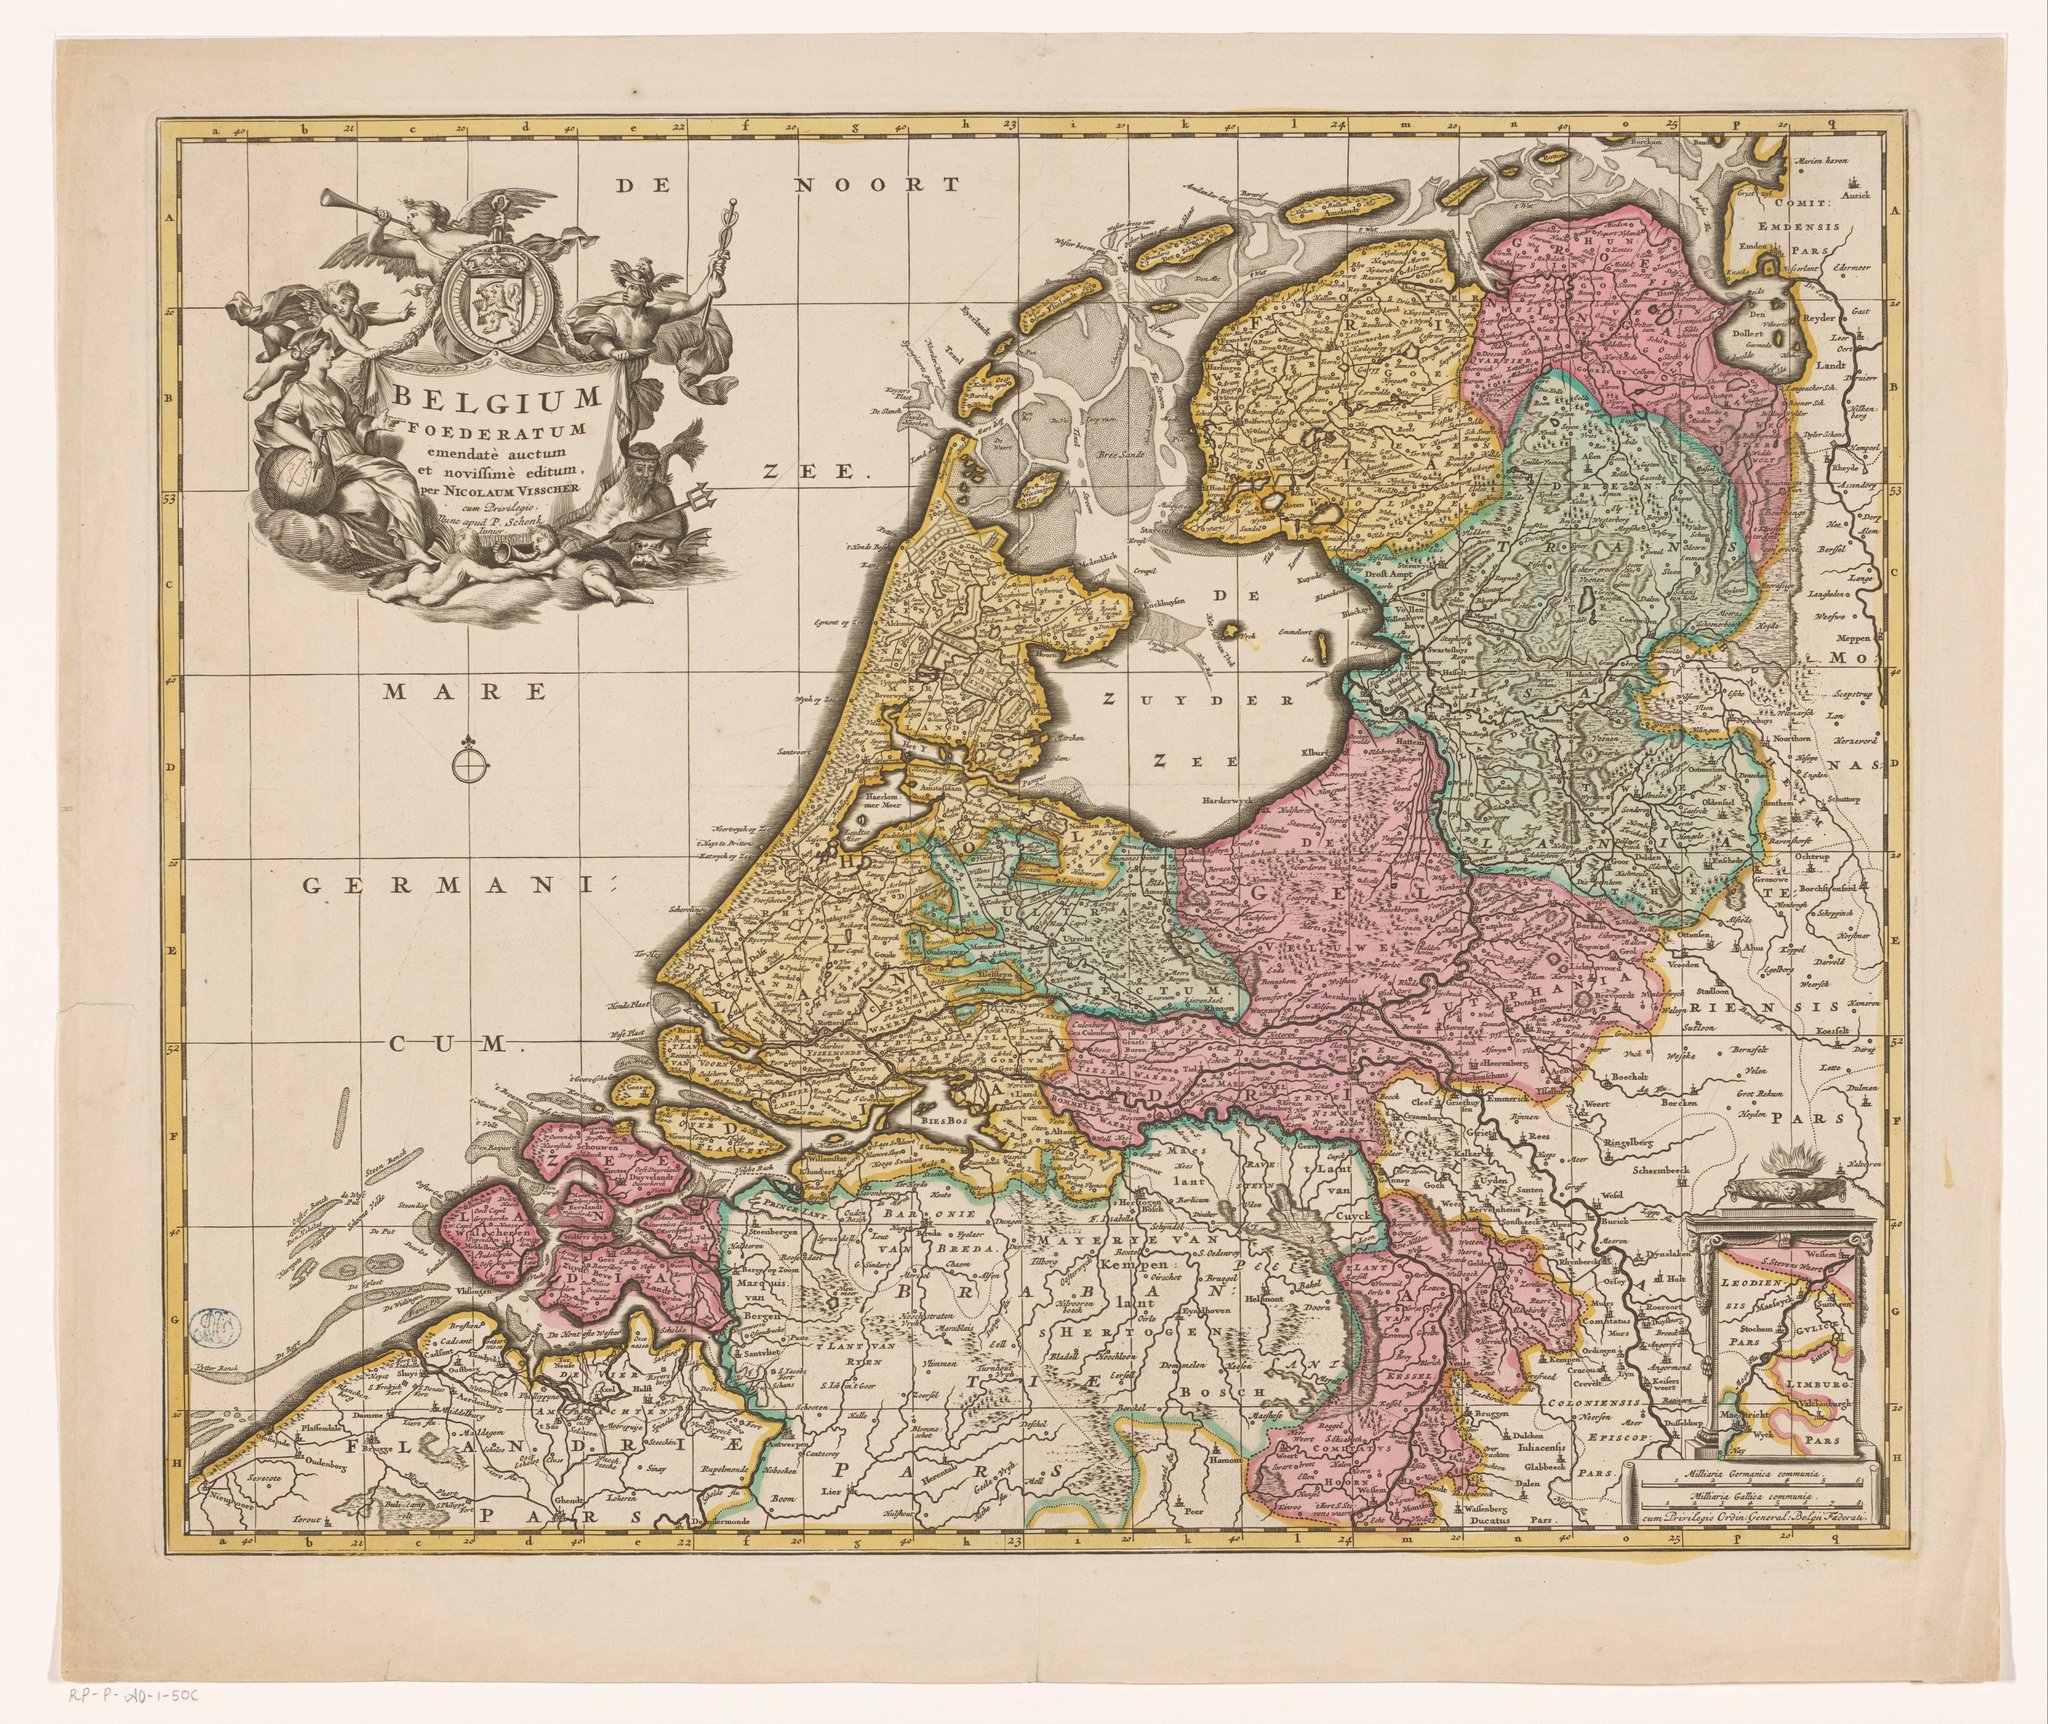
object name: map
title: Kaart van de Republiek der Zeven Verenigde Nederlanden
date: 1658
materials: paper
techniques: engraving, hand coloring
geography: amsterdam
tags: (story of) neptune (poseidon), coat of arms (as symbol of the state, etc.), maps of separate countries or regions, (story of) mercury (hermes), urania (one of the muses); 'urania' (ripa), fame; 'fama', 'fama buona', 'fama chiara' (ripa), netherlands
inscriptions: collector's mark: Lugt 195, collector's mark: Lugt 2228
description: Linksboven cartouche met titel en het wapen van de Republiek, daaromheen zijn verschillende figuren afgebeeld: Urania, Fama, Mercurius, Neptunus en een aantal putti. Rechtsonder een inzetkaartje van een deel van het huidige Limburg (deel dat destijds tot Staats-Brabant behoorde). Daaronder schaalstok: Milliaria Germanica communia, Milliaria Gallica communia. De kaart is voorzien van een coördinaten-net en een gradenverdeling langs de randen.